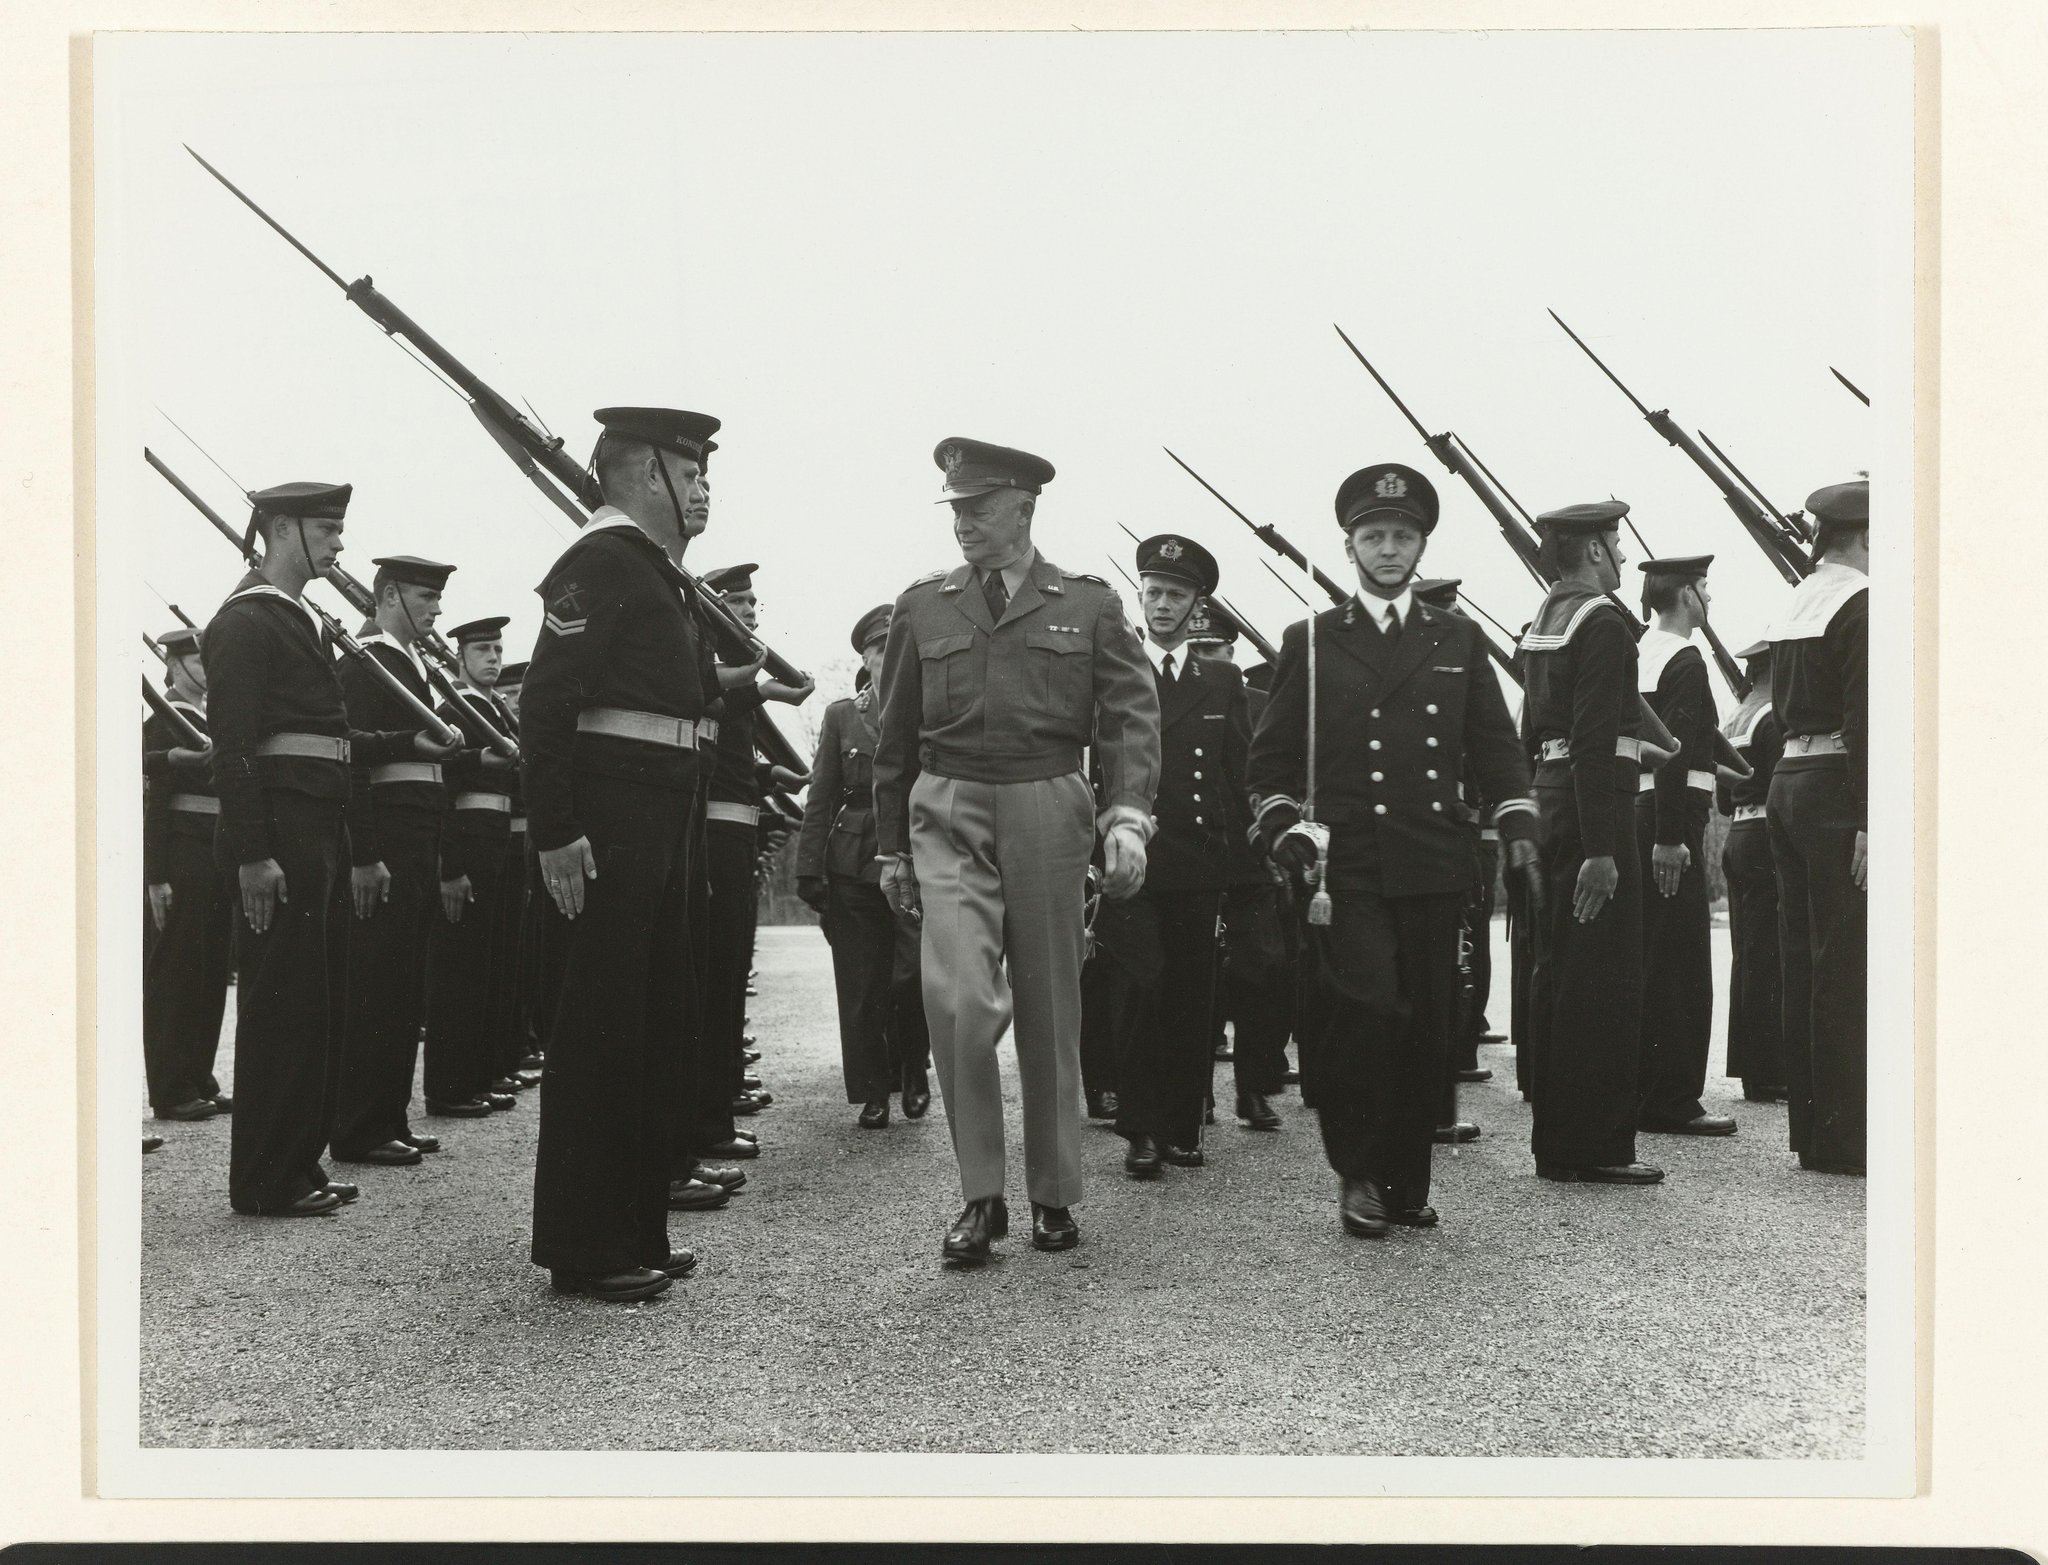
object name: photograph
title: Eisenhower inspecteert Nederlandse marine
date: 1905-1951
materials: photographic support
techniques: photography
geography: hilversum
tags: nato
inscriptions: date: ‘may 1951’, inscription: ‘GEN DWIGHT D EISENHOWER IS SHOWN INSPECTING DUTCH NAVAL PERSONNEL AT / HILVERSUM NAVAL TRAINING STATION HOLLAND, THIS IS IN CONNECTION WITH / THE NORTH ATLANTIC TREATY’, stamp: ‘SHAPE PHOTOGRAPH...’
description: Generaal Eisenhower met achter hem militairen van de zeemacht.Aan weerszijden staan matrozen in het gelid. Vermoedelijk is dit het bezoek dat Eisenhower als opperbevelhebber van de Nato bracht op 8/ 9 mei. Met bijbehorend blad met opschrift.